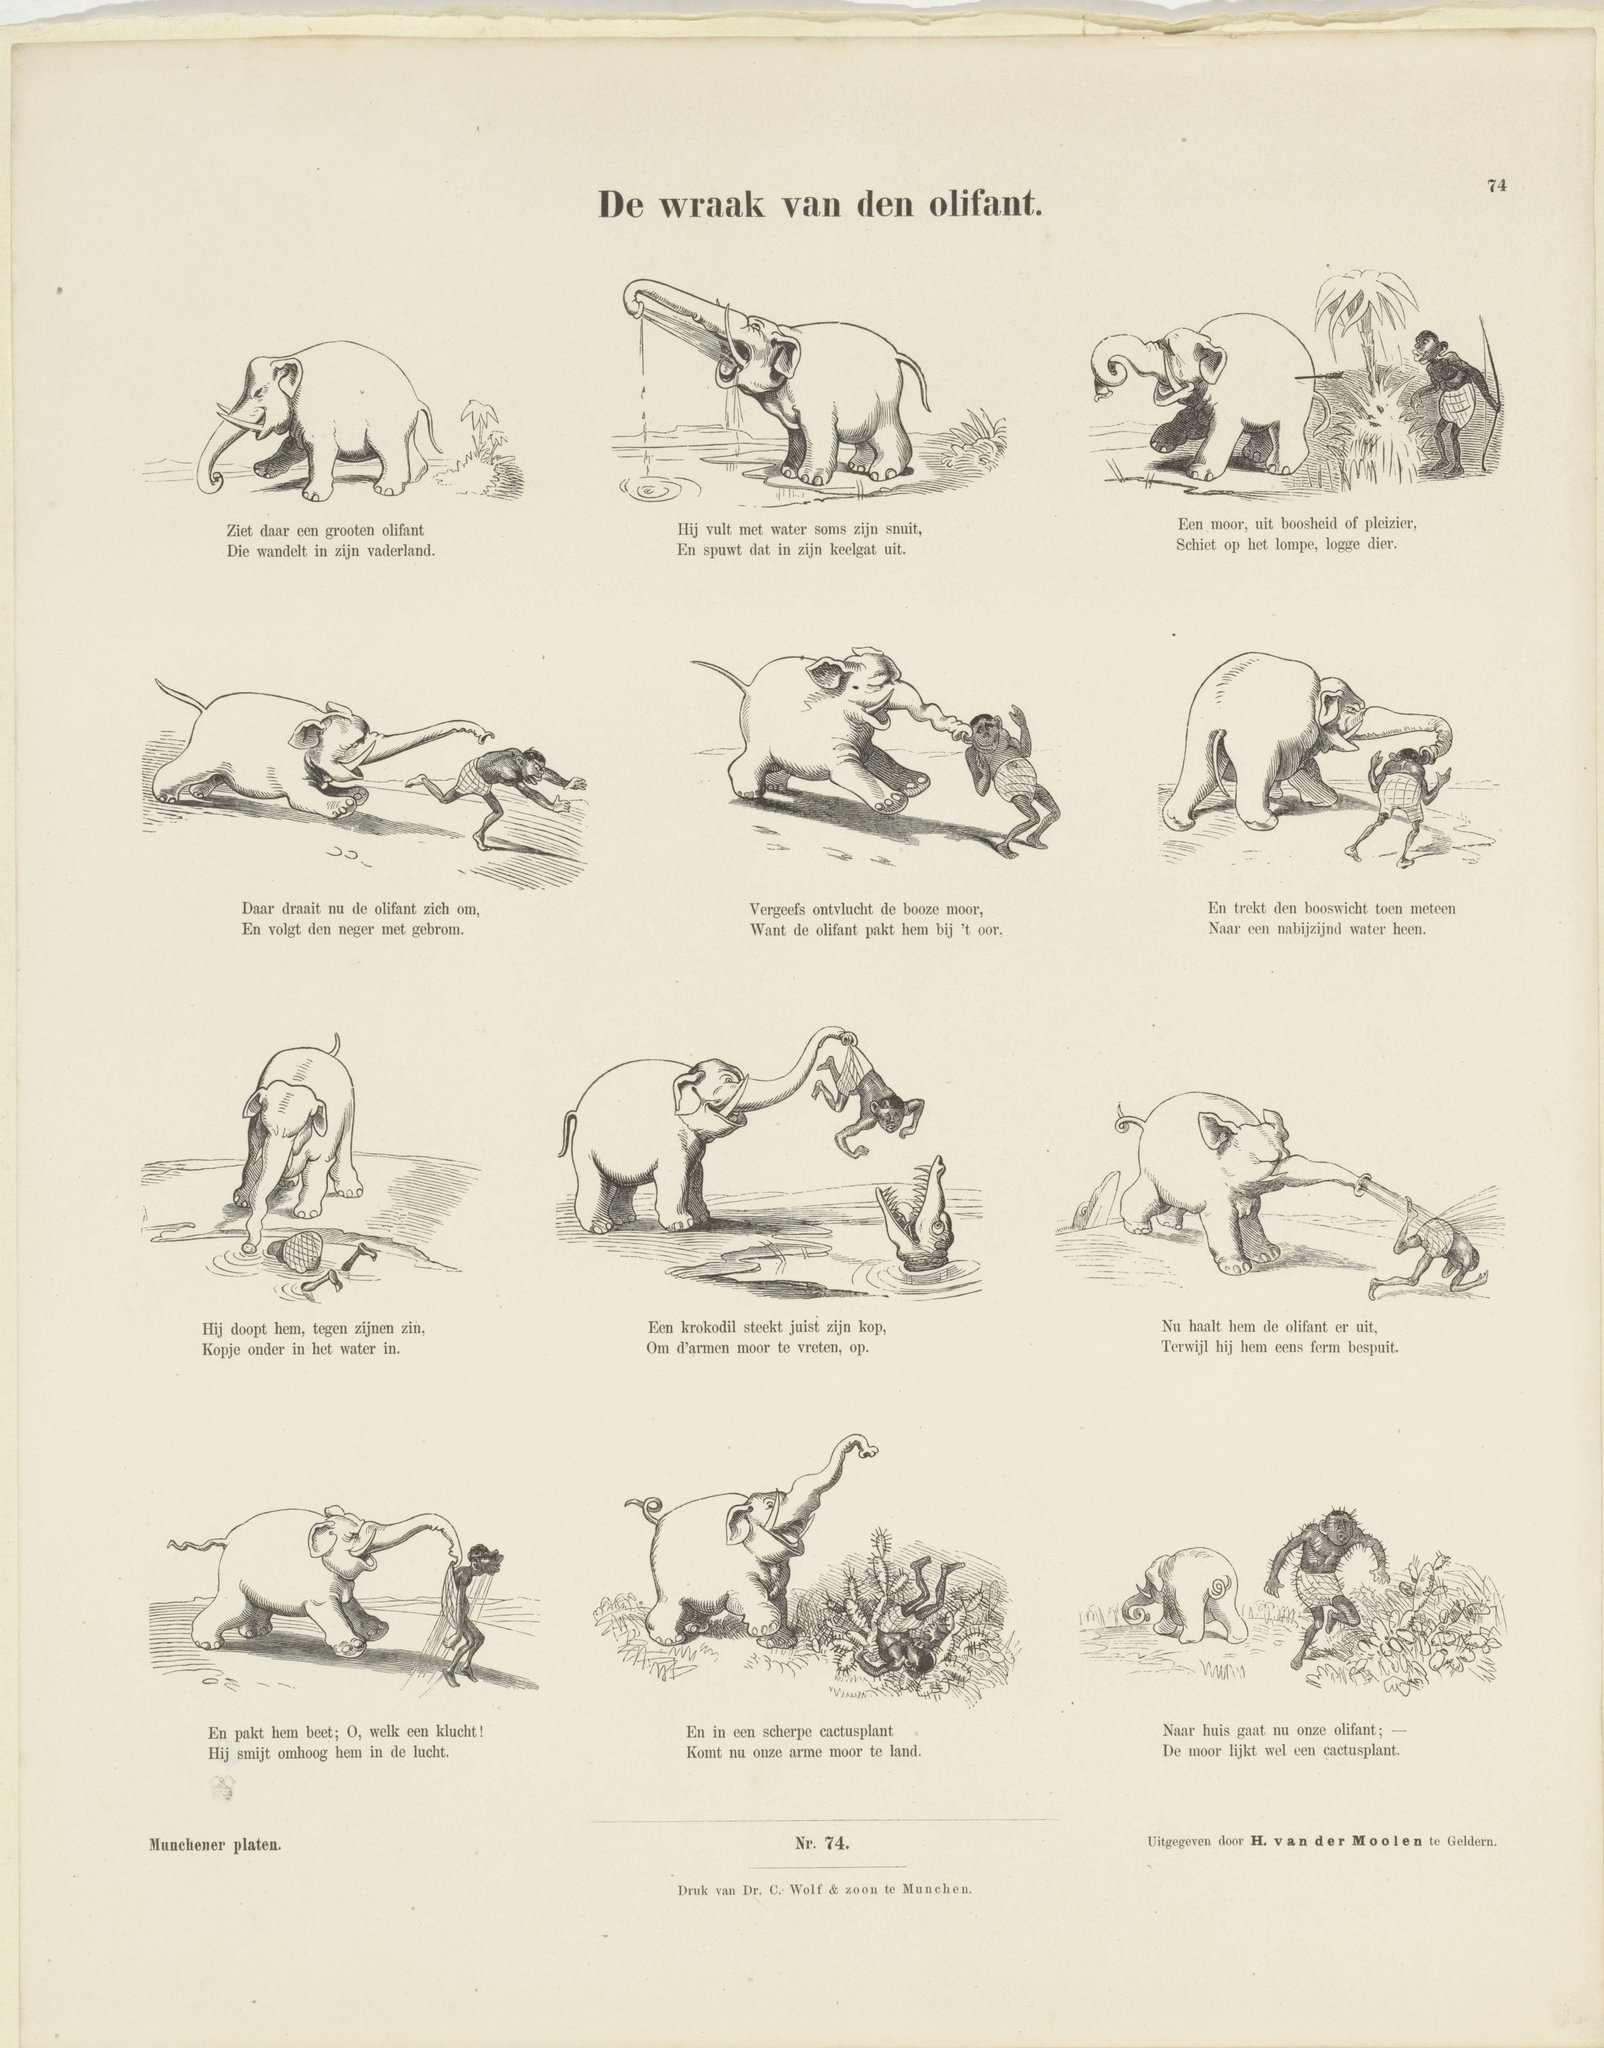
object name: popular print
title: De wraak van den olifant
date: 1843-1920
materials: paper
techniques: letterpress printing, engraving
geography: munich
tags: crocodiles: crocodile, hunter, plants and herbs: cactus, trunked animals: elephant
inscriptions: collector's mark: Lugt 2760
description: Blad met 12 voorstellingen over een olifant die wraak neemt op een Afrikaanse jager die hem probeert te doden. Onder elke afbeelding een tweeregelig vers. Genummerd midden onder: Nro. 74. Genummerd rechtsboven: 74.